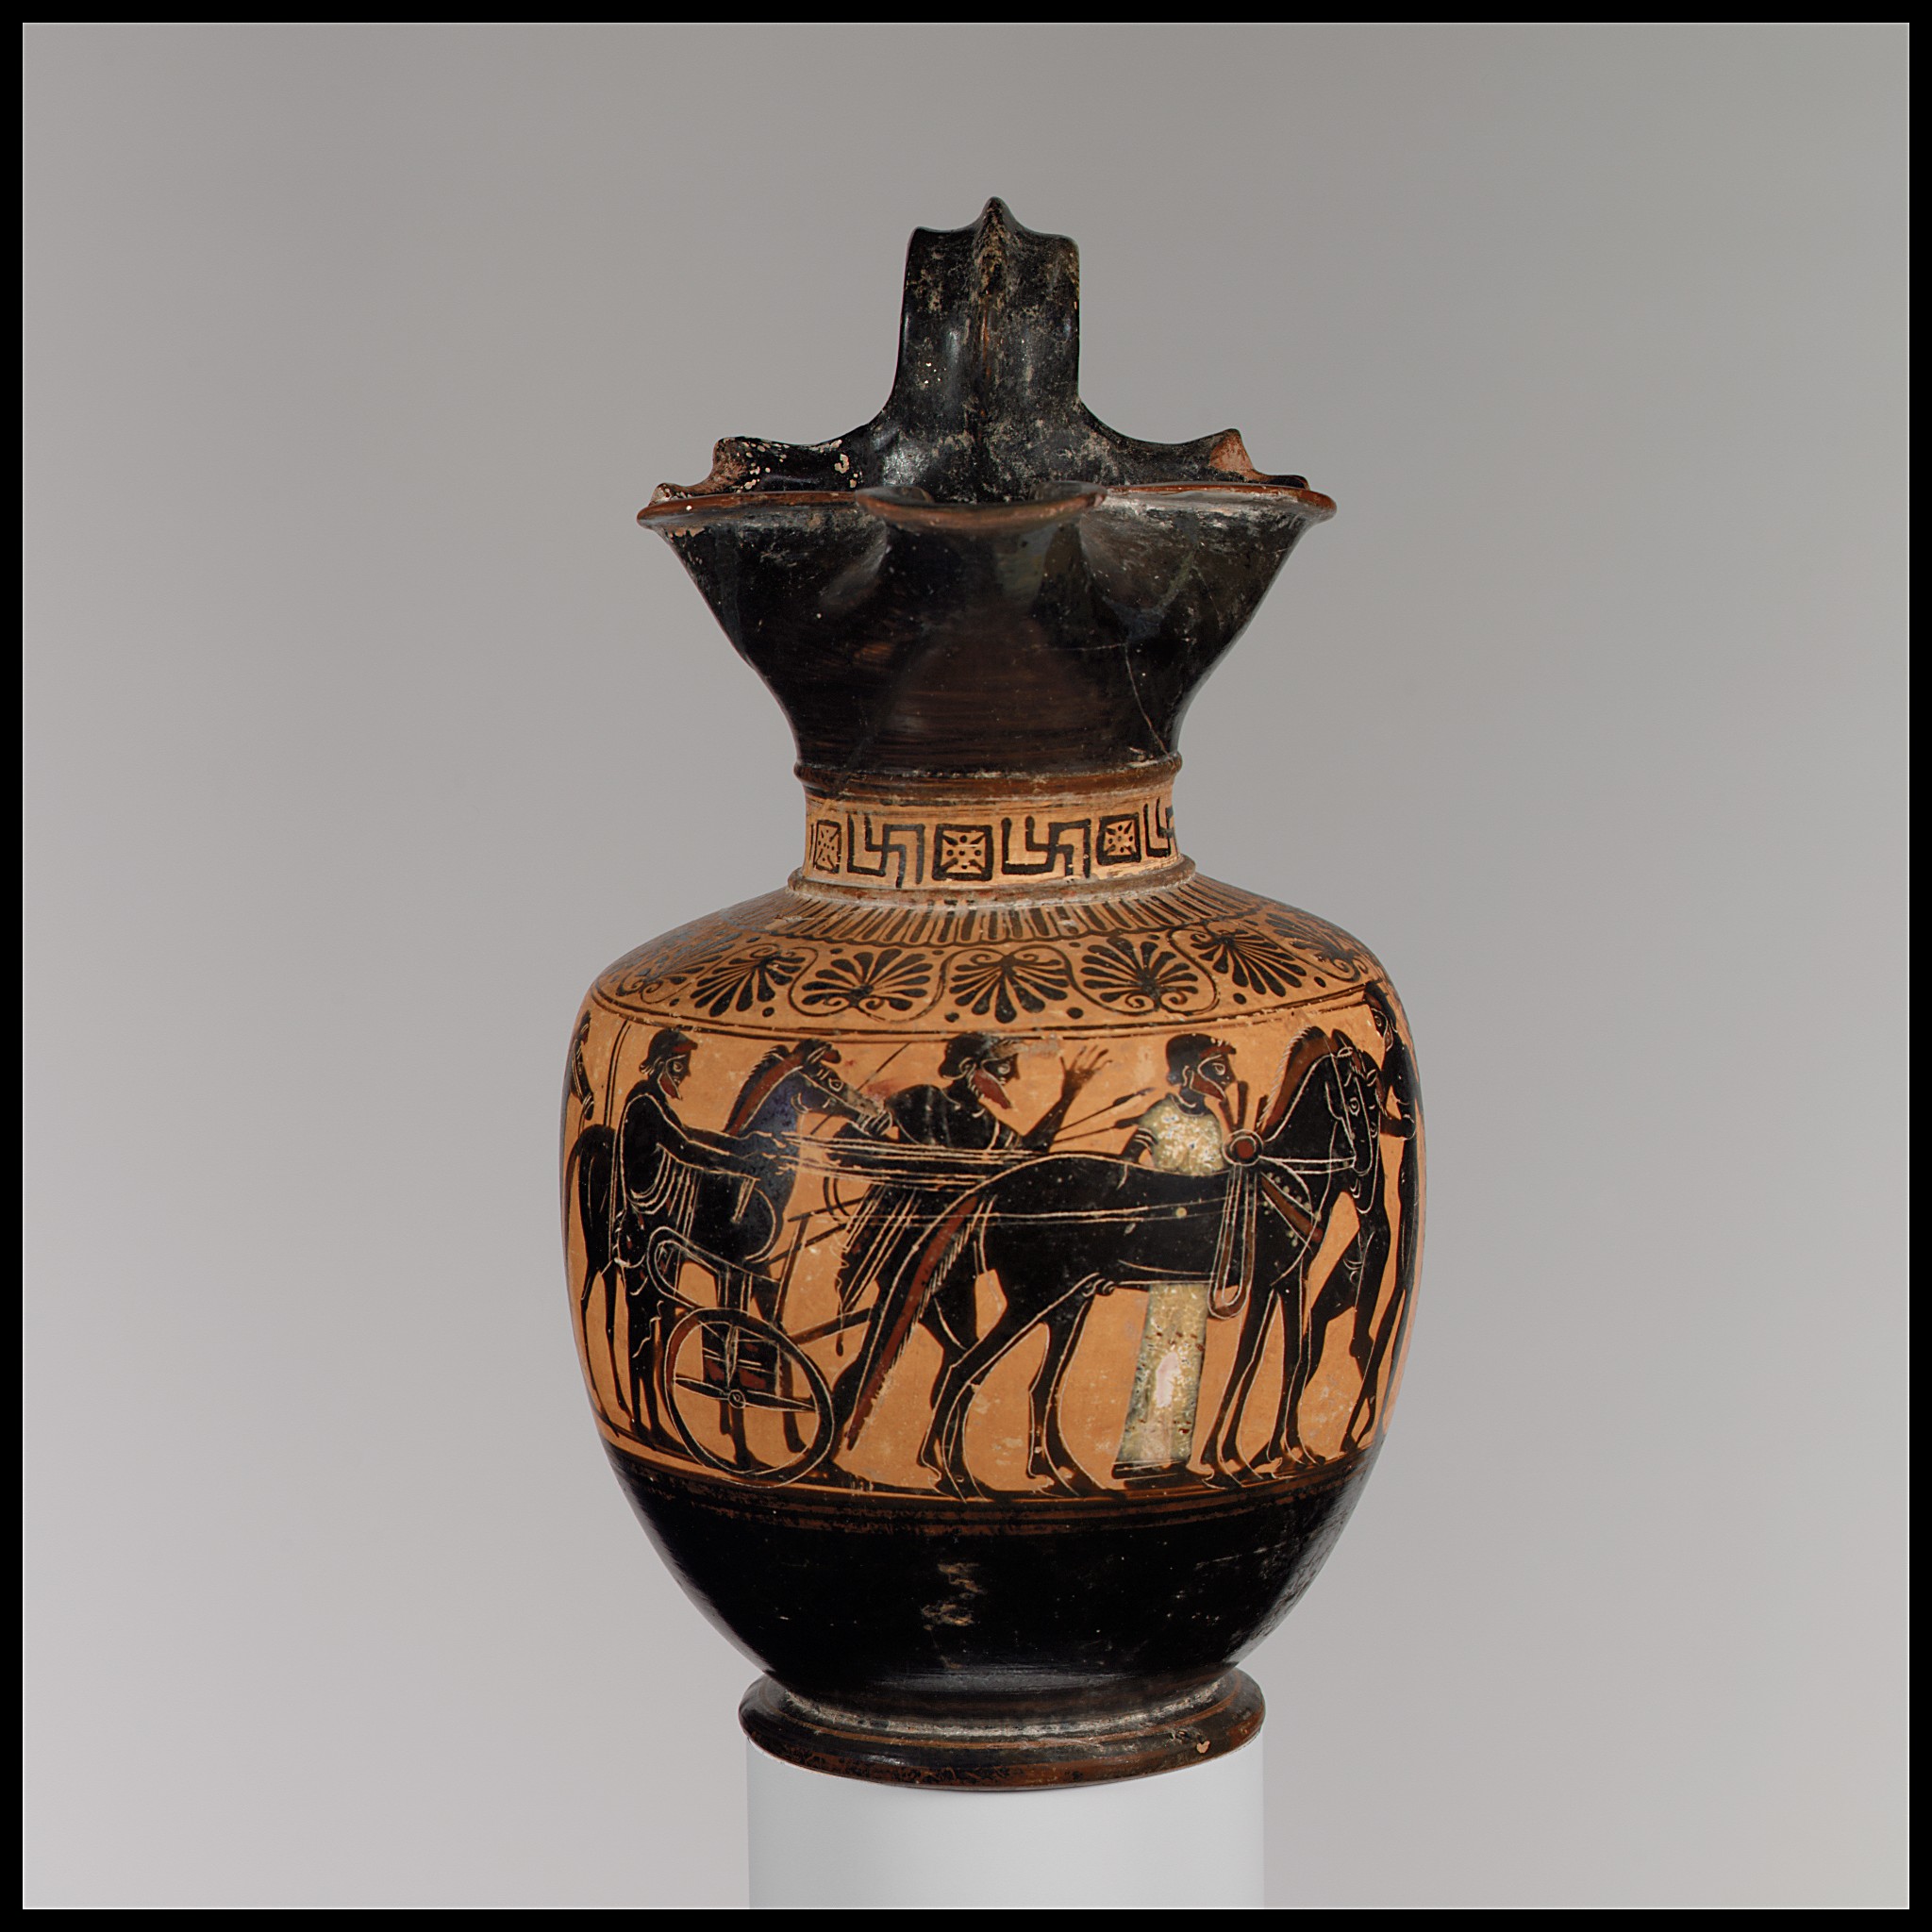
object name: oinochoe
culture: greek, attic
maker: gela painter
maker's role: artist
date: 500 BCE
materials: terracotta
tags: men,horses,chariots